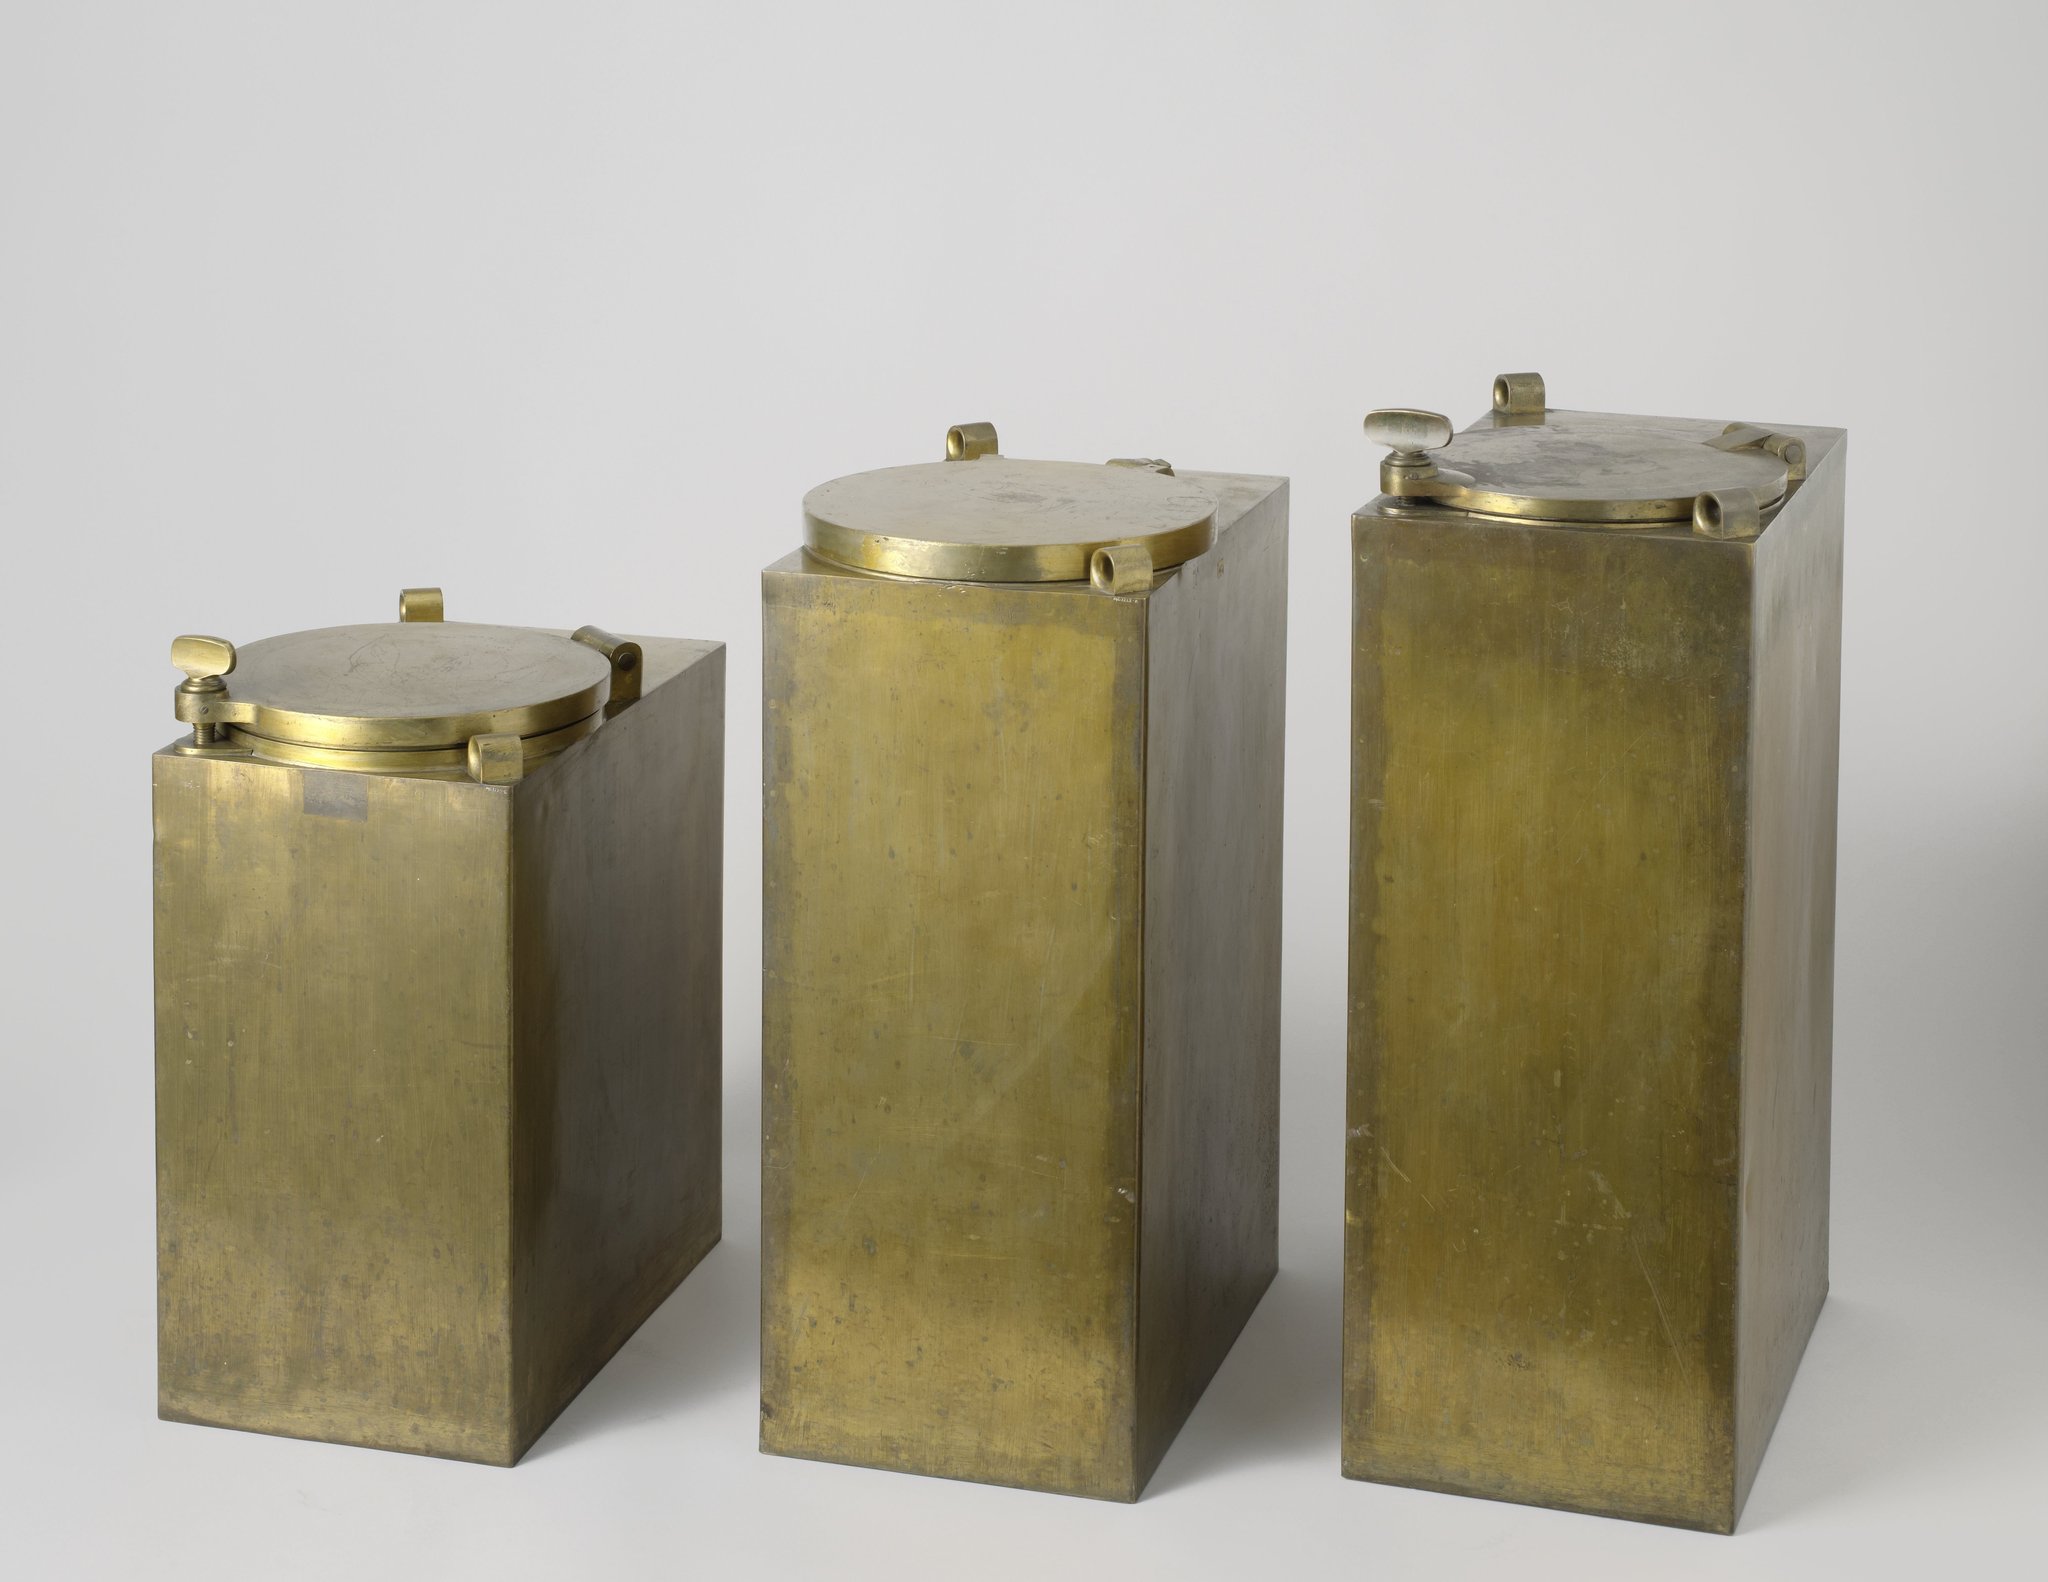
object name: gun accessory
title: Three Powder Chests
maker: Anonymous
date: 1866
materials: brass, plastic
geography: united kingdom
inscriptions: inscription, on lid B: ‘3’, inscription, on lid A: ‘2’, inscription, on lid C: ‘1’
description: In december 1866 liet ktz. Jansen drie buskruitkisten uit Engeland overkomen ter vergelijking met Nederlandse kruitkisten. Zij werden in Nederland niet ingevoerd.